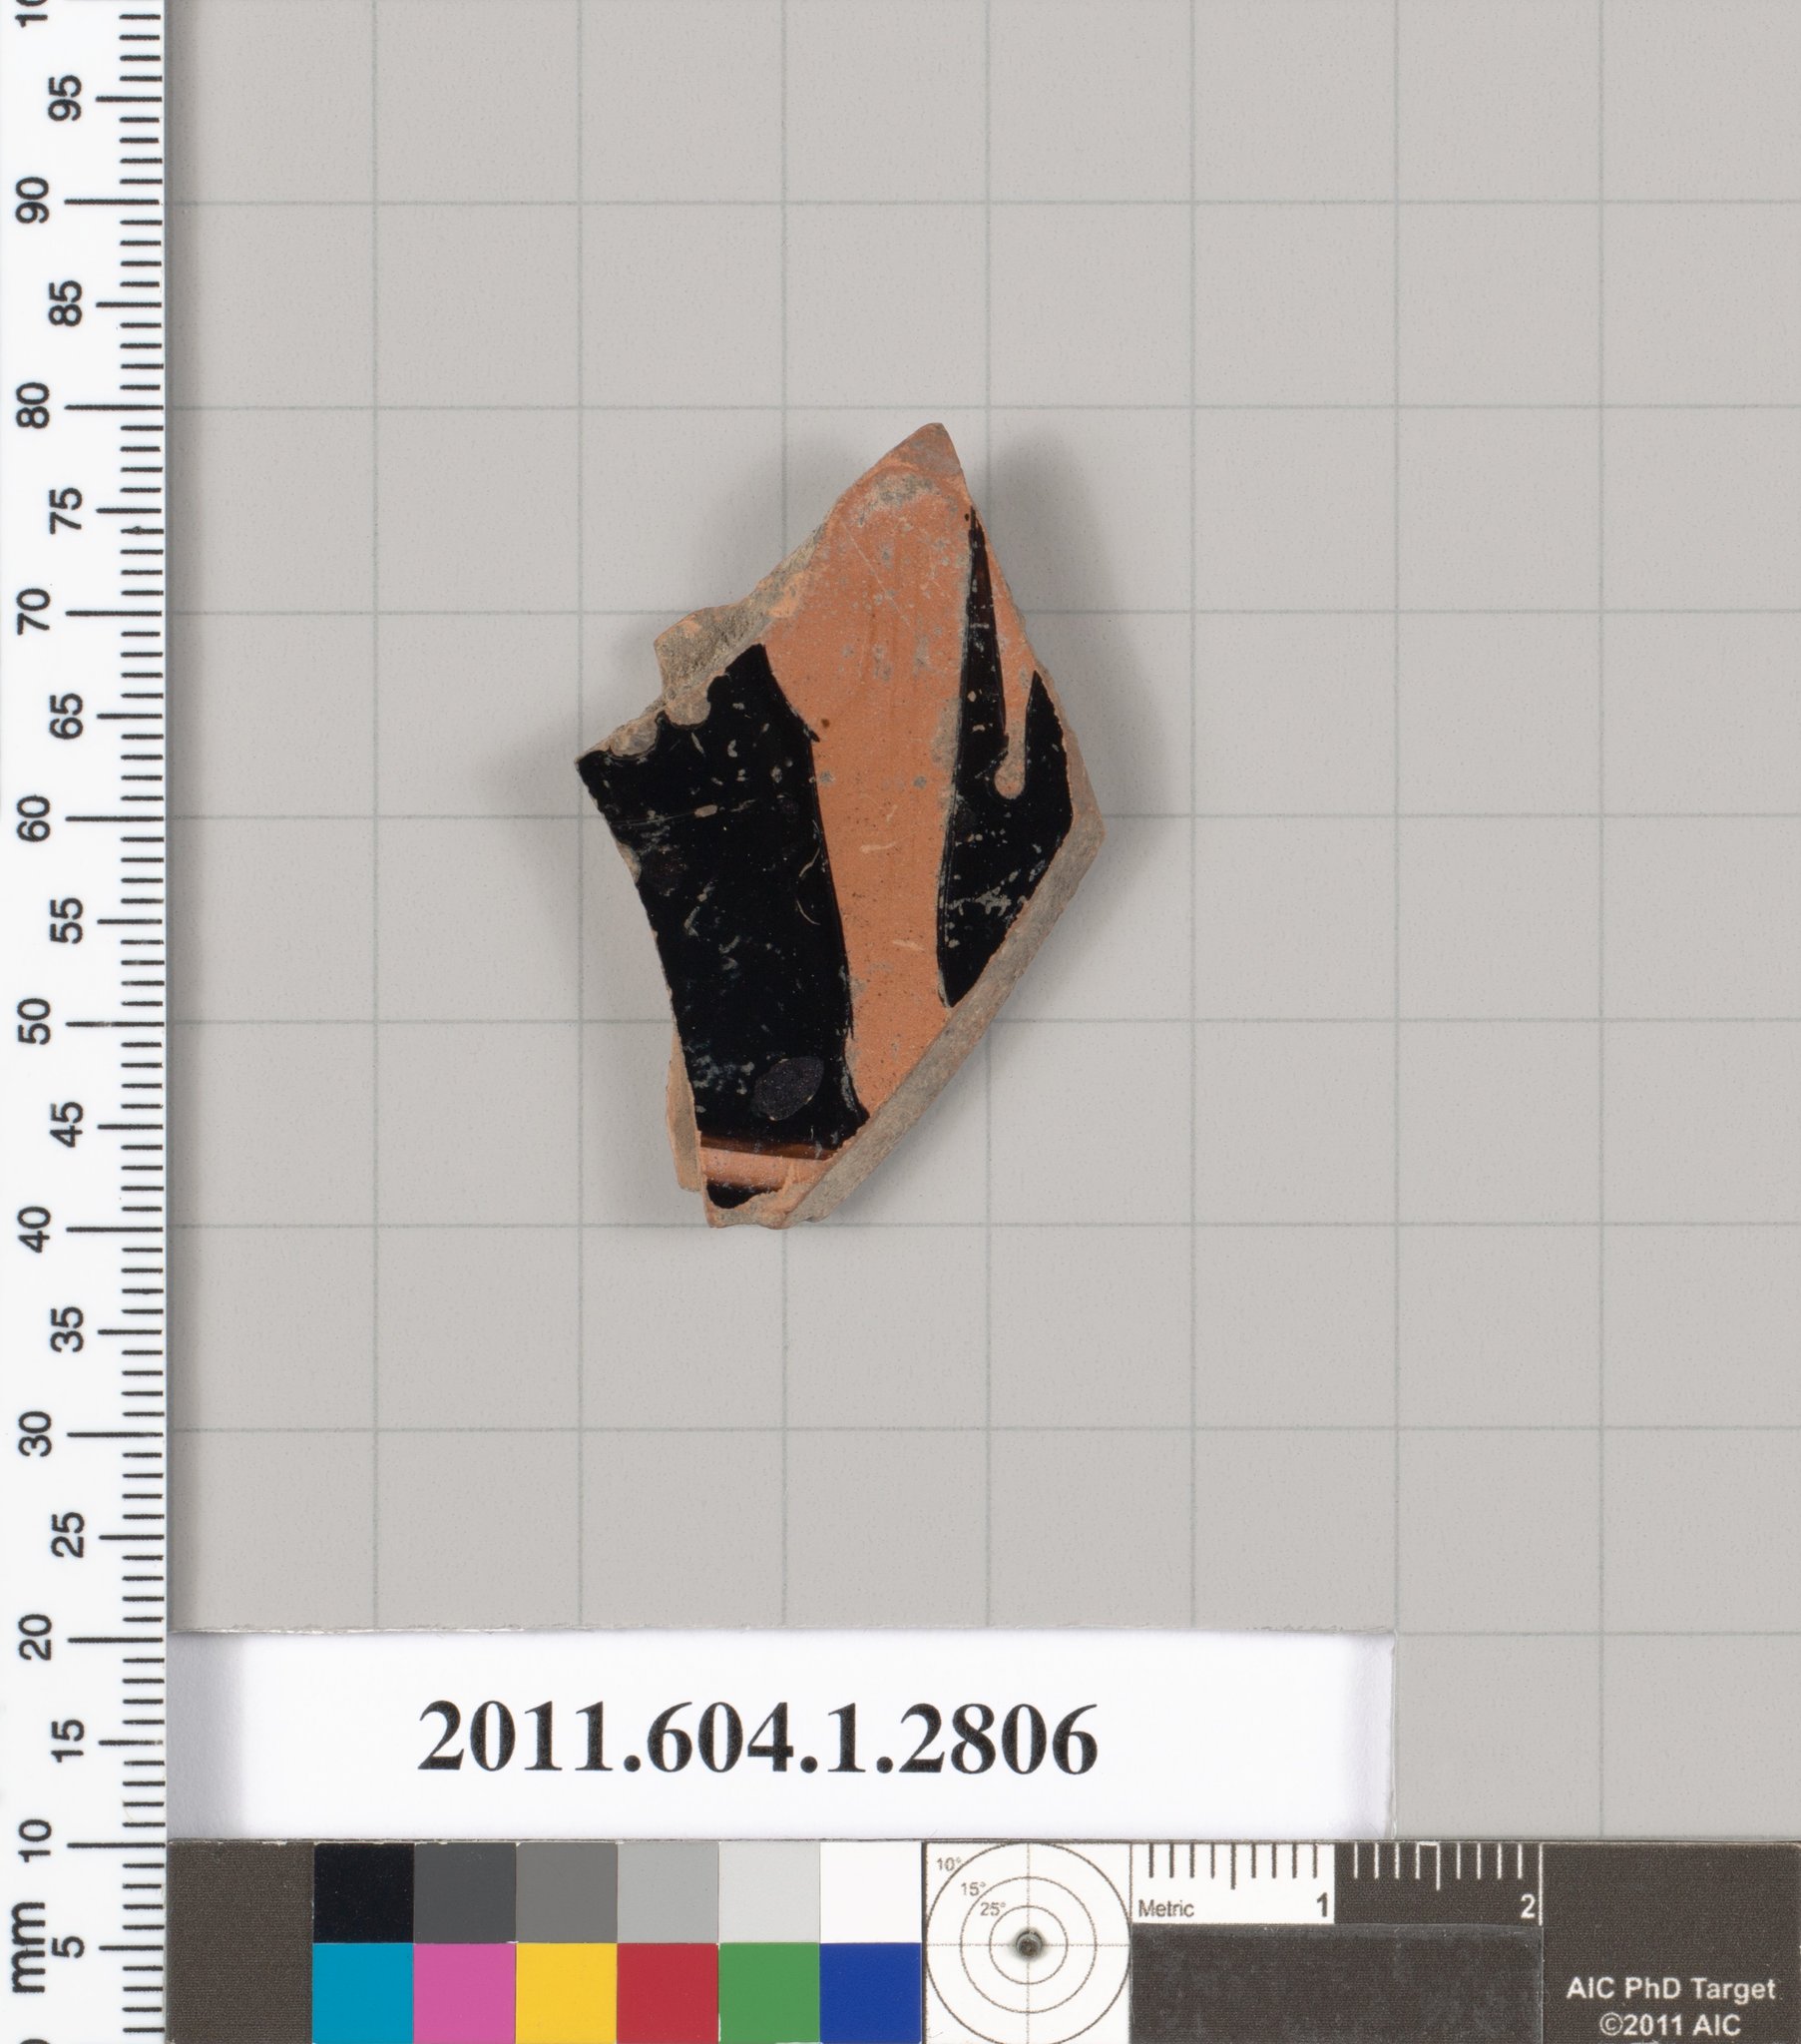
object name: kylix fragment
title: Terracotta fragment of a kylix (drinking cup)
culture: greek, attic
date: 520-500 BCE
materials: terracotta